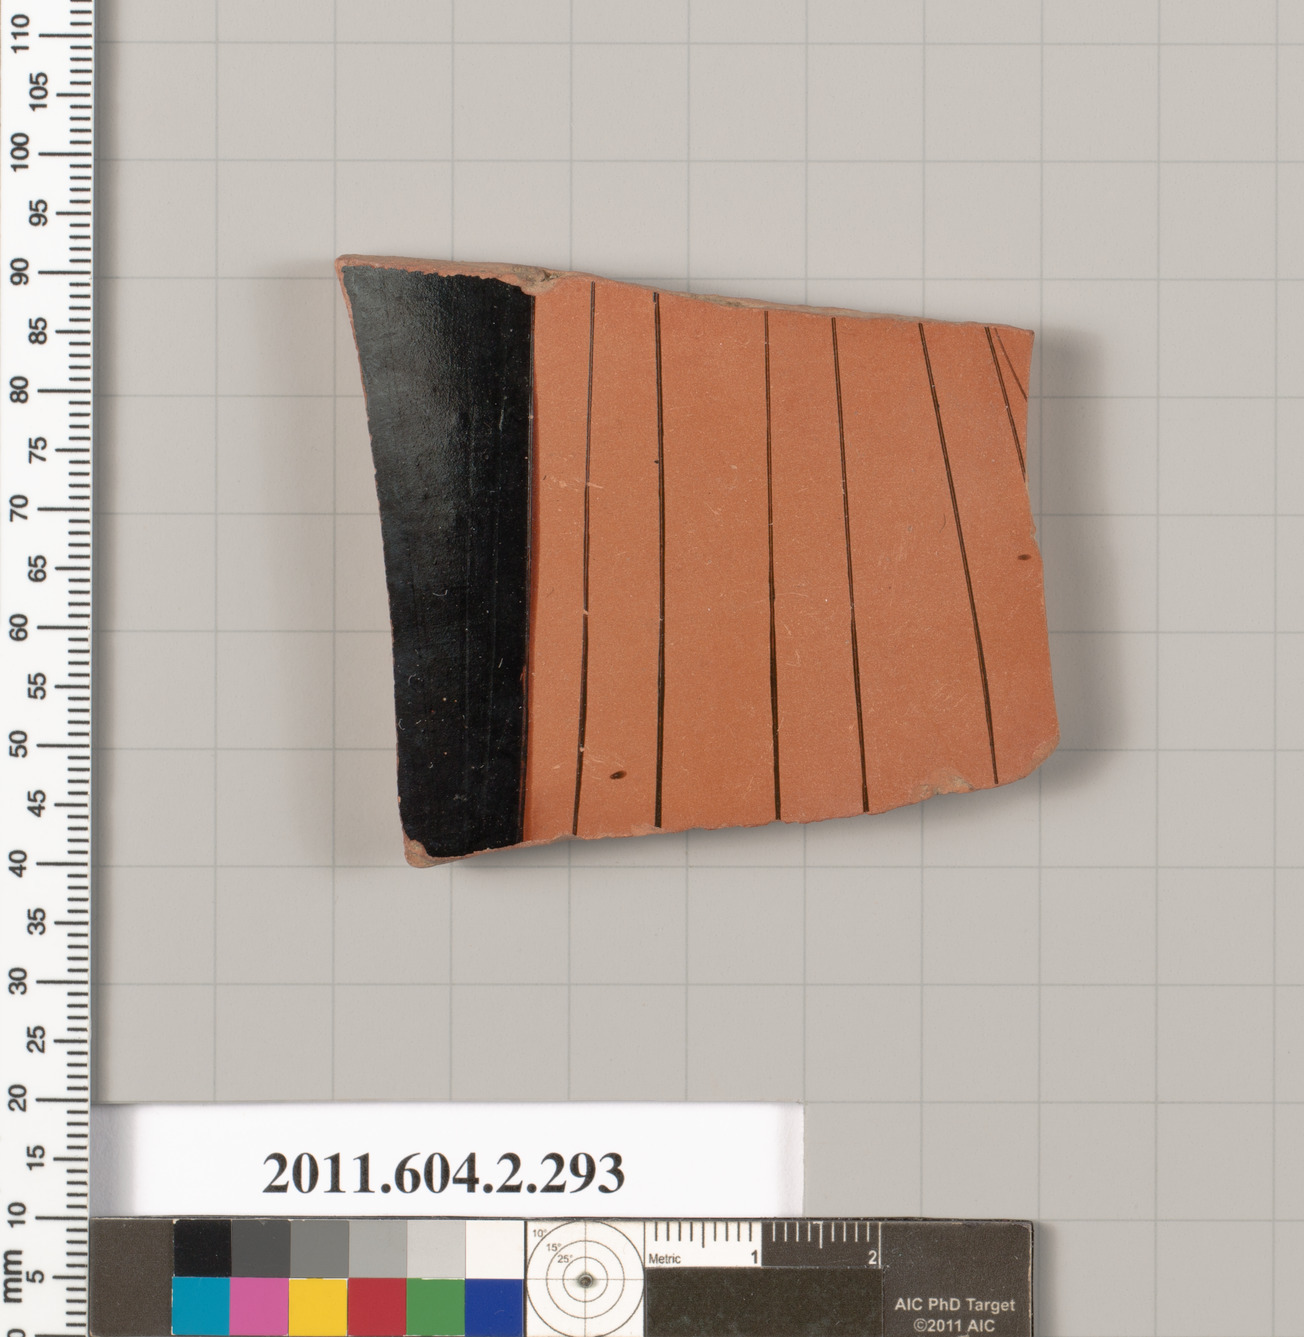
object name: column krater fragment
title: Terracotta fragment of a column-krater (bowl for mixing wine and water)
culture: greek, attic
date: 460-440 BCE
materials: terracotta